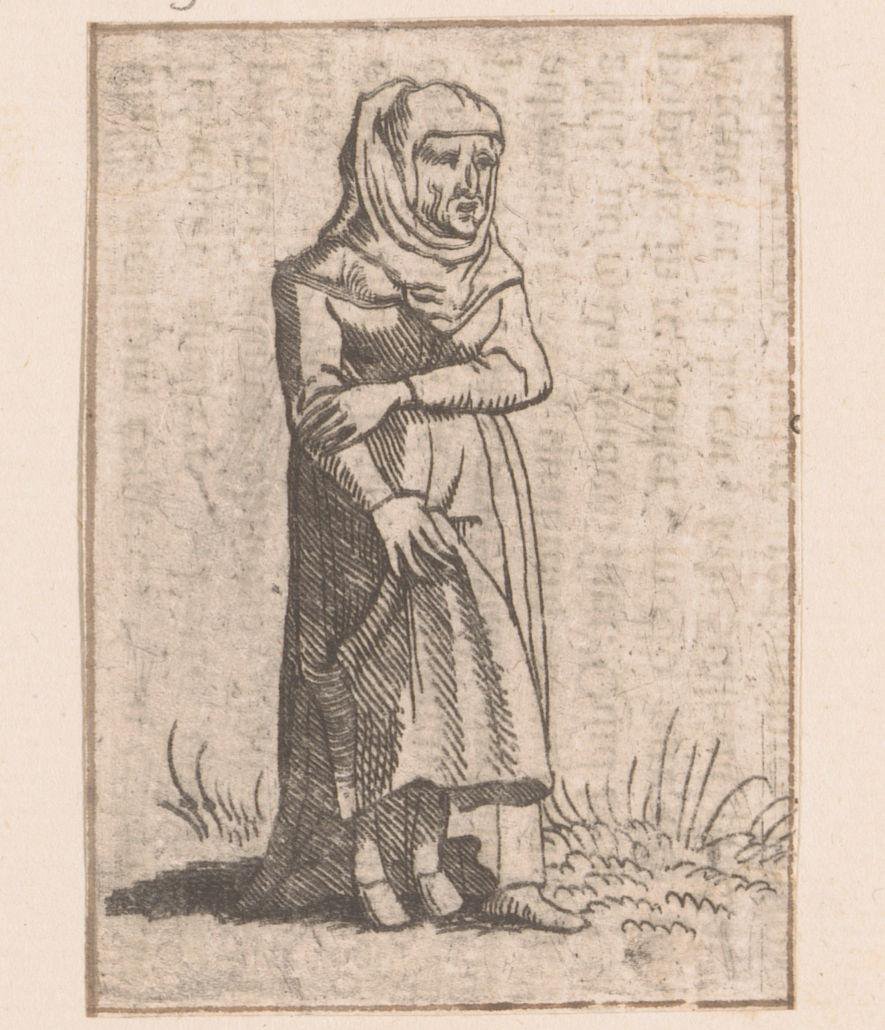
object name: book illustration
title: Illustraties uit de Lof der Zotheid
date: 1516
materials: paper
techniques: etching, letterpress printing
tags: old woman, folly, foolishness; 'pazzia', 'sciocchezza', 'stoltitia' (ripa), lovers; courting, flirting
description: Prent afkomstig uit: Erasmus, Desiderius. Morias enkomion (...). Bazel: Johann Rudolf Genath, 1676. De prenten hierin zijn naar tekeningen die Hans en Ambrosius Holbein maakten voor de theoloog Oswald Myconius in diens uitgave van de Moriae encomium (Lof der Zotheid) van 1516.